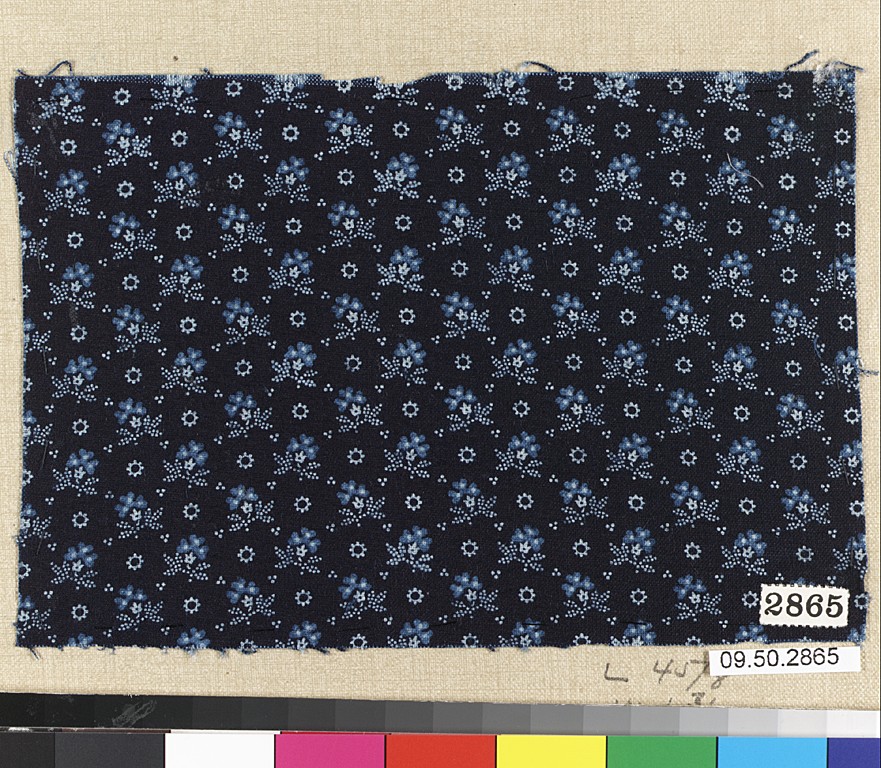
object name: piece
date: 1801-1900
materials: cotton